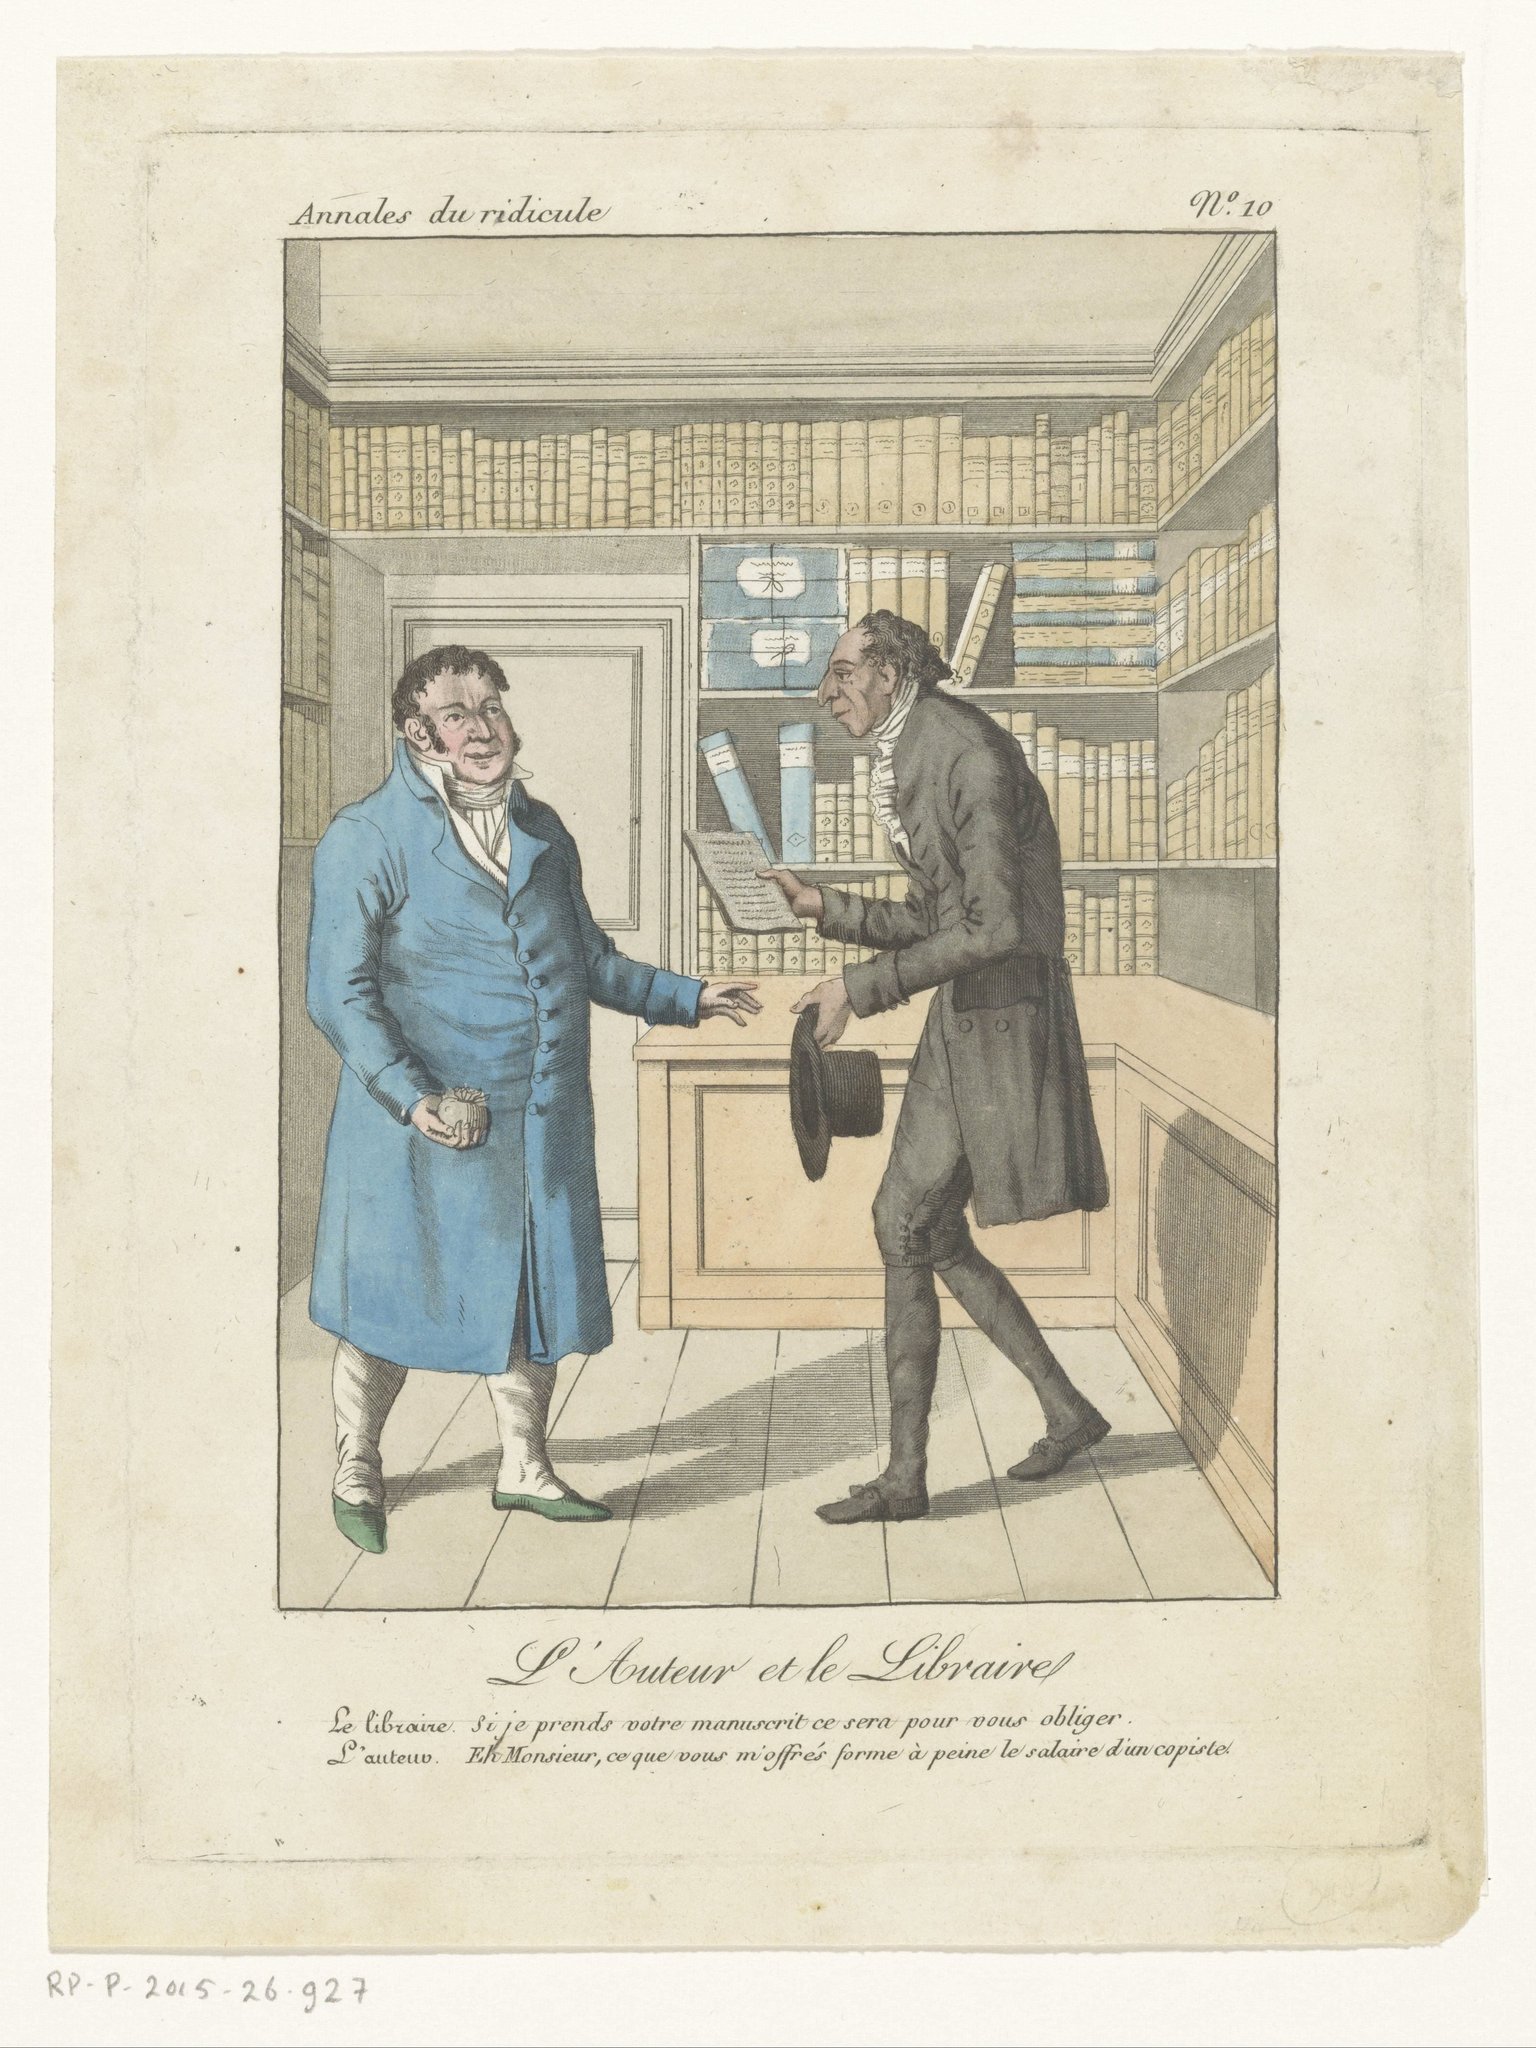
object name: print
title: Satirische taferelen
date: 1815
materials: paper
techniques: etching, hand coloring, soft ground etching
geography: paris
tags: publishing, publisher, writer, poet, author, book-shop, bookseller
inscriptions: collector's mark: Lugt 4779, collector's mark: Lugt 2228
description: Prent afkomstig uit: Annales du ridicule, ou Scènes et caricatures parisiennes, tussen januari 1815 en oktober 1815 uitgegeven in 12 delen door de Parijse uitgevers Édouard Hocquart, de weduwe van Jean-Baptiste Jeunehomme en François-Marie-Joseph Moronval.